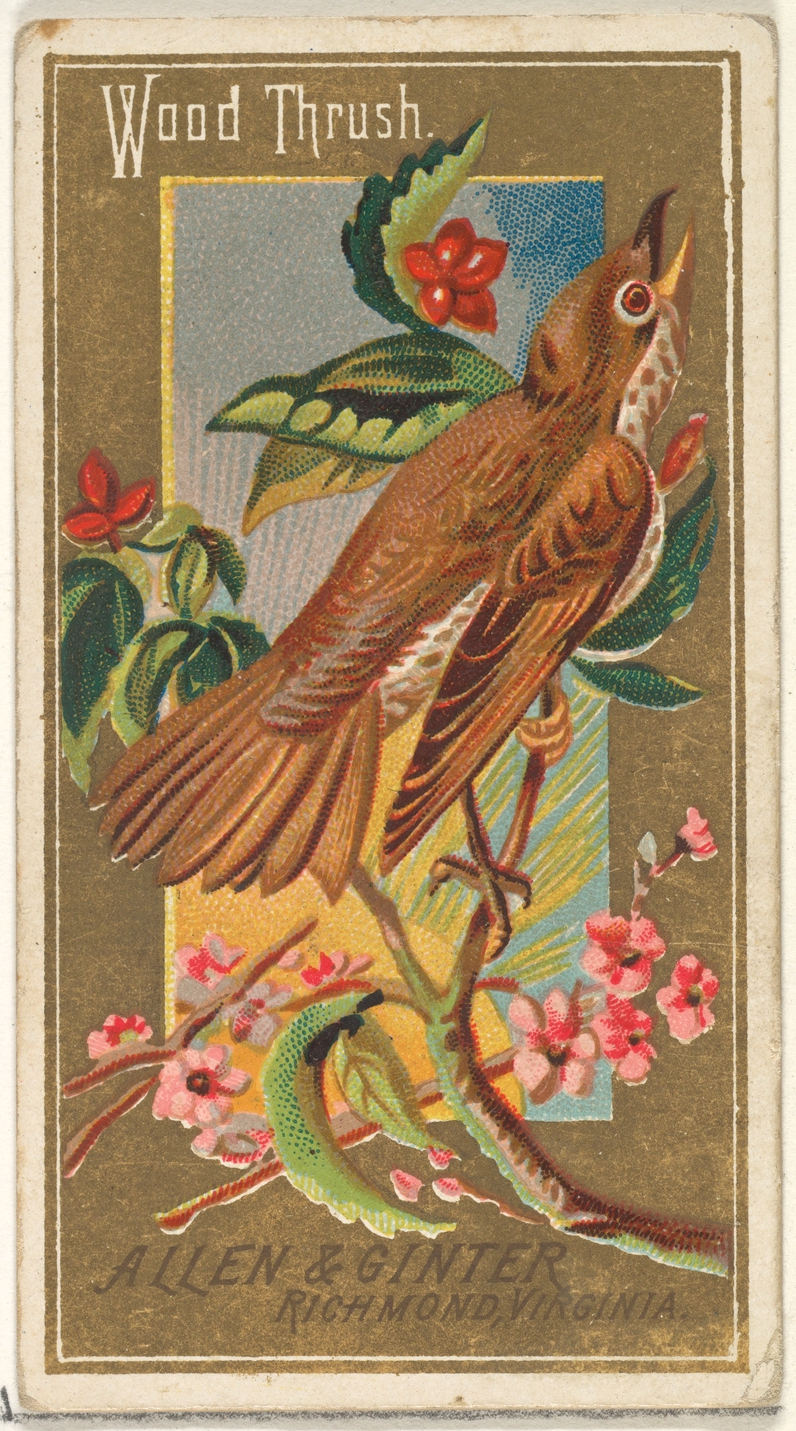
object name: print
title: Wood Thrush, from the Birds of America series (N4) for Allen & Ginter Cigarettes Brands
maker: allen & ginter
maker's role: publisher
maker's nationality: american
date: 1888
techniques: color lithograph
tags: birds